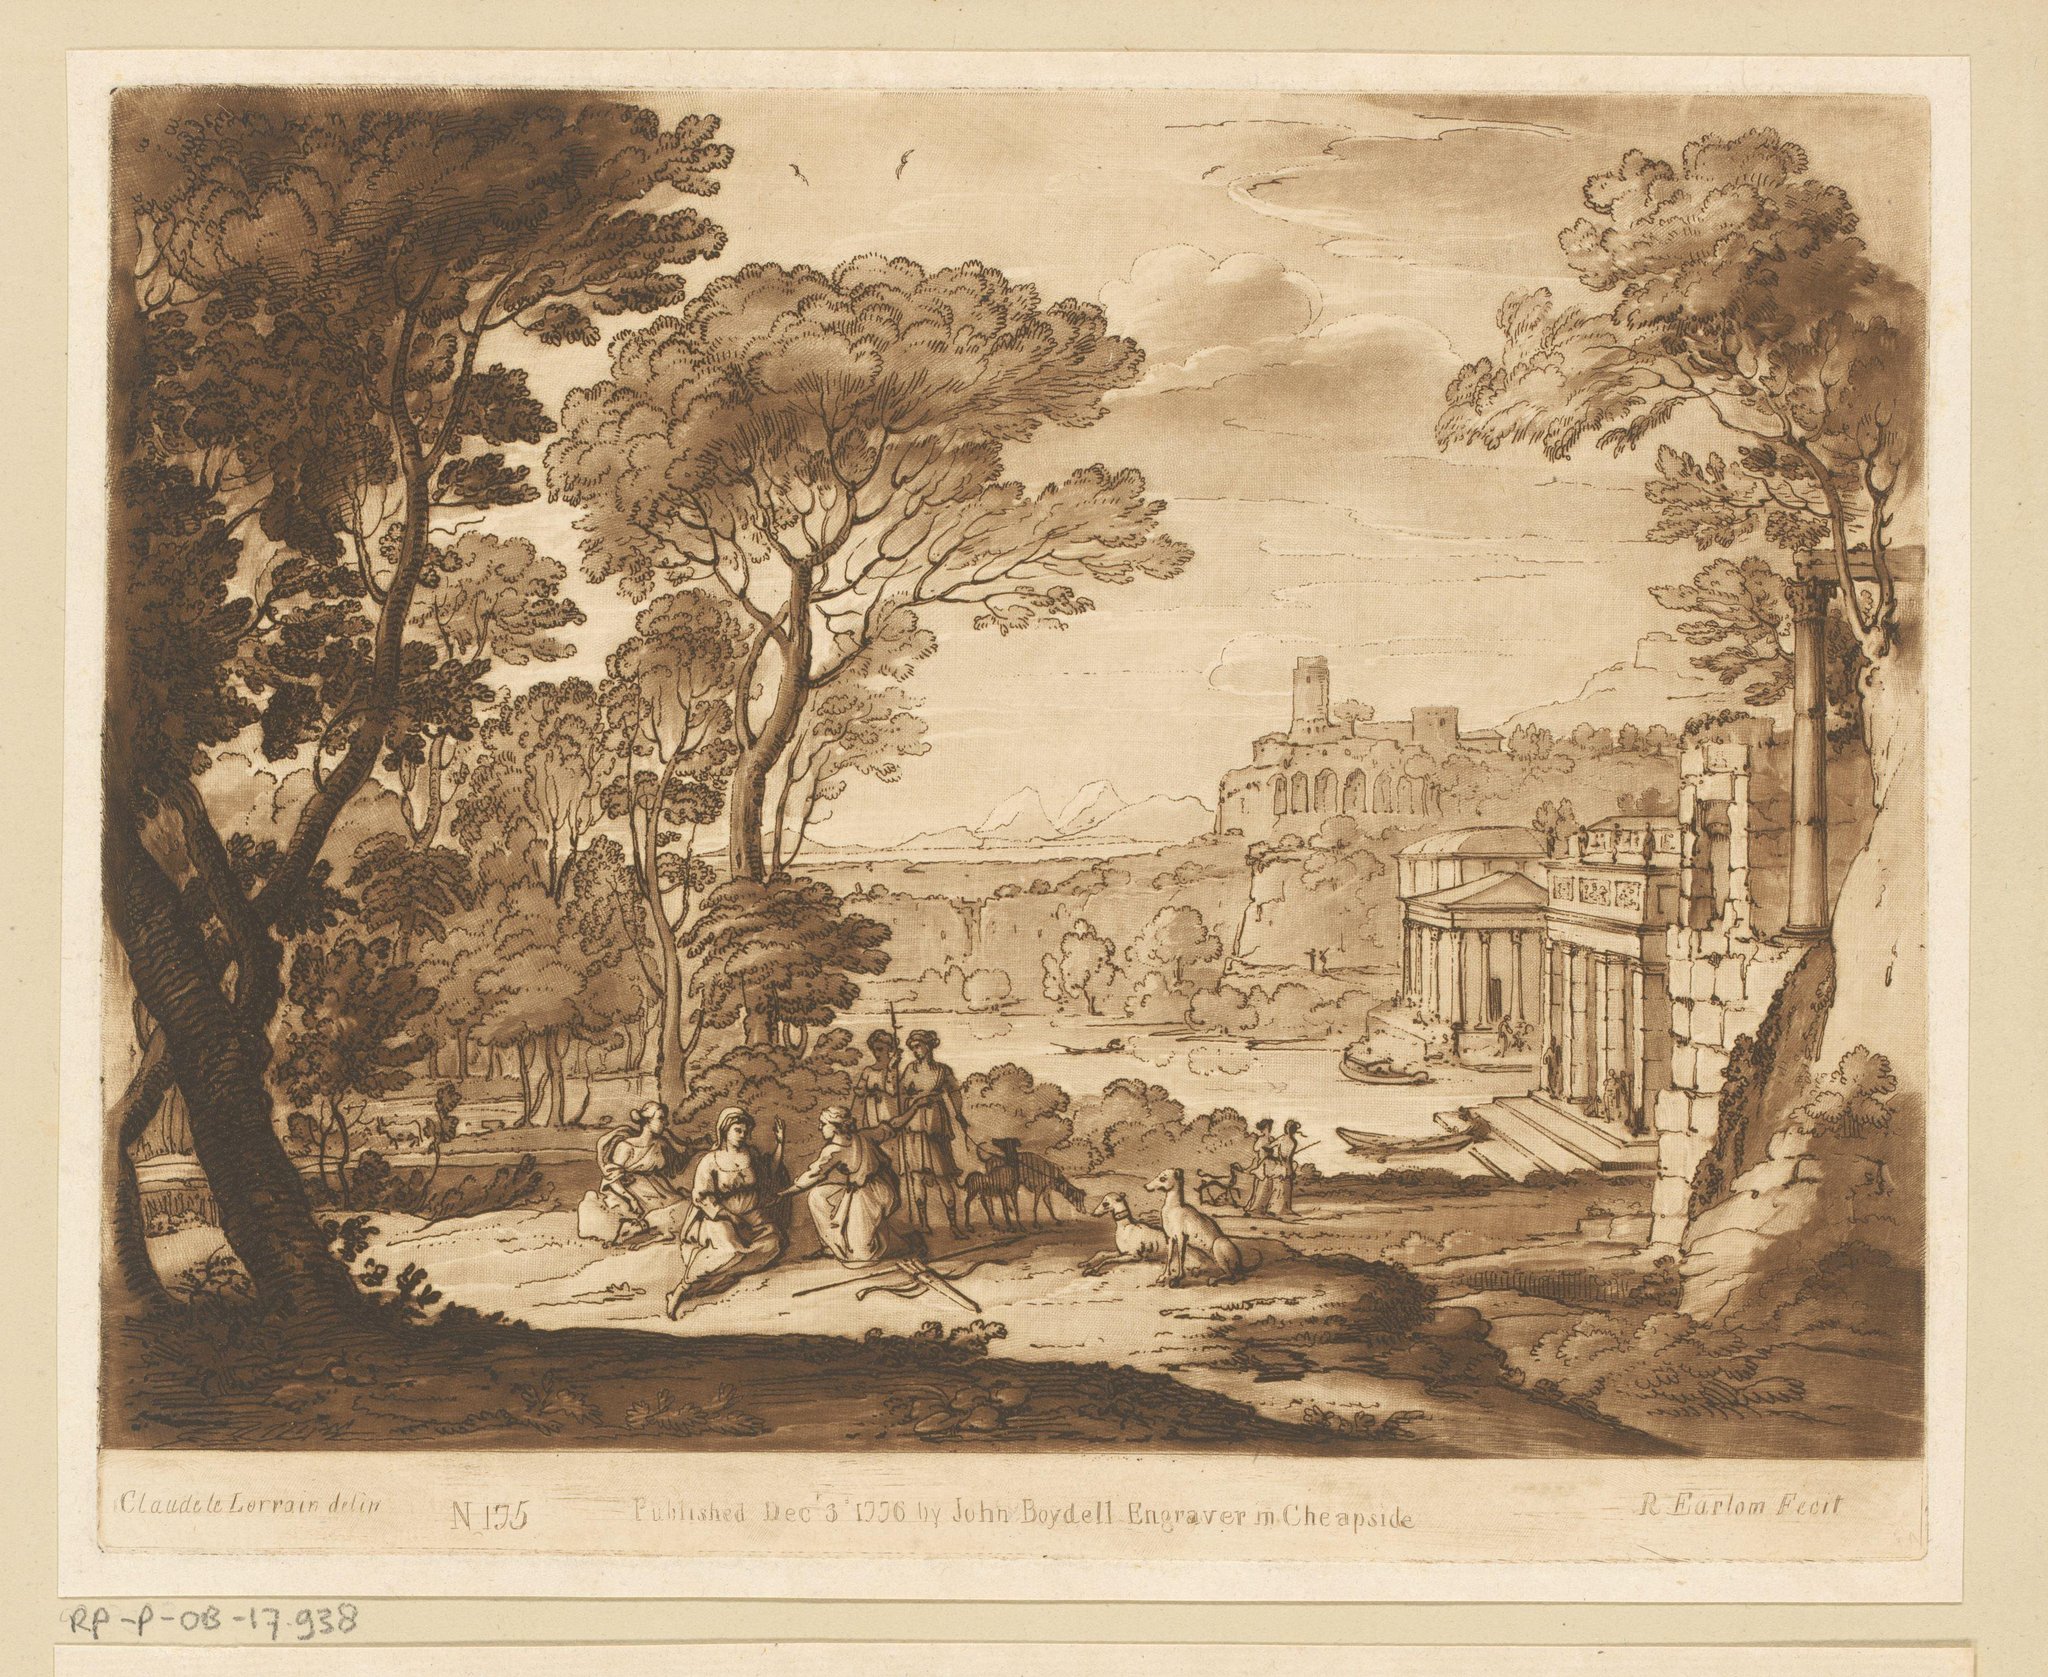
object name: print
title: Prenten naar tekeningen van Claude Lorrain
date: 1776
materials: paper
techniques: etching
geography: london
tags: egeria changed into a fountain: when egeria's grief at the death of numa pompilius can not be assuaged, she melts away in tears, and is changed into a fountain (ovid, metamorphoses xv 546), landscape with ruins - ii - ideal landscapes, lake - hh - ideal landscapes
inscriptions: date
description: Vanaf 1774 publiceerde John Boydell tweehonderd prenten naar het tekeningenboek Liber Veritatis van Claude Lorrain, in het bezit van de hertogen van Cavendish. Deze prenten werden vanaf 1777 in twee volumes gebundeld uitgegeven.